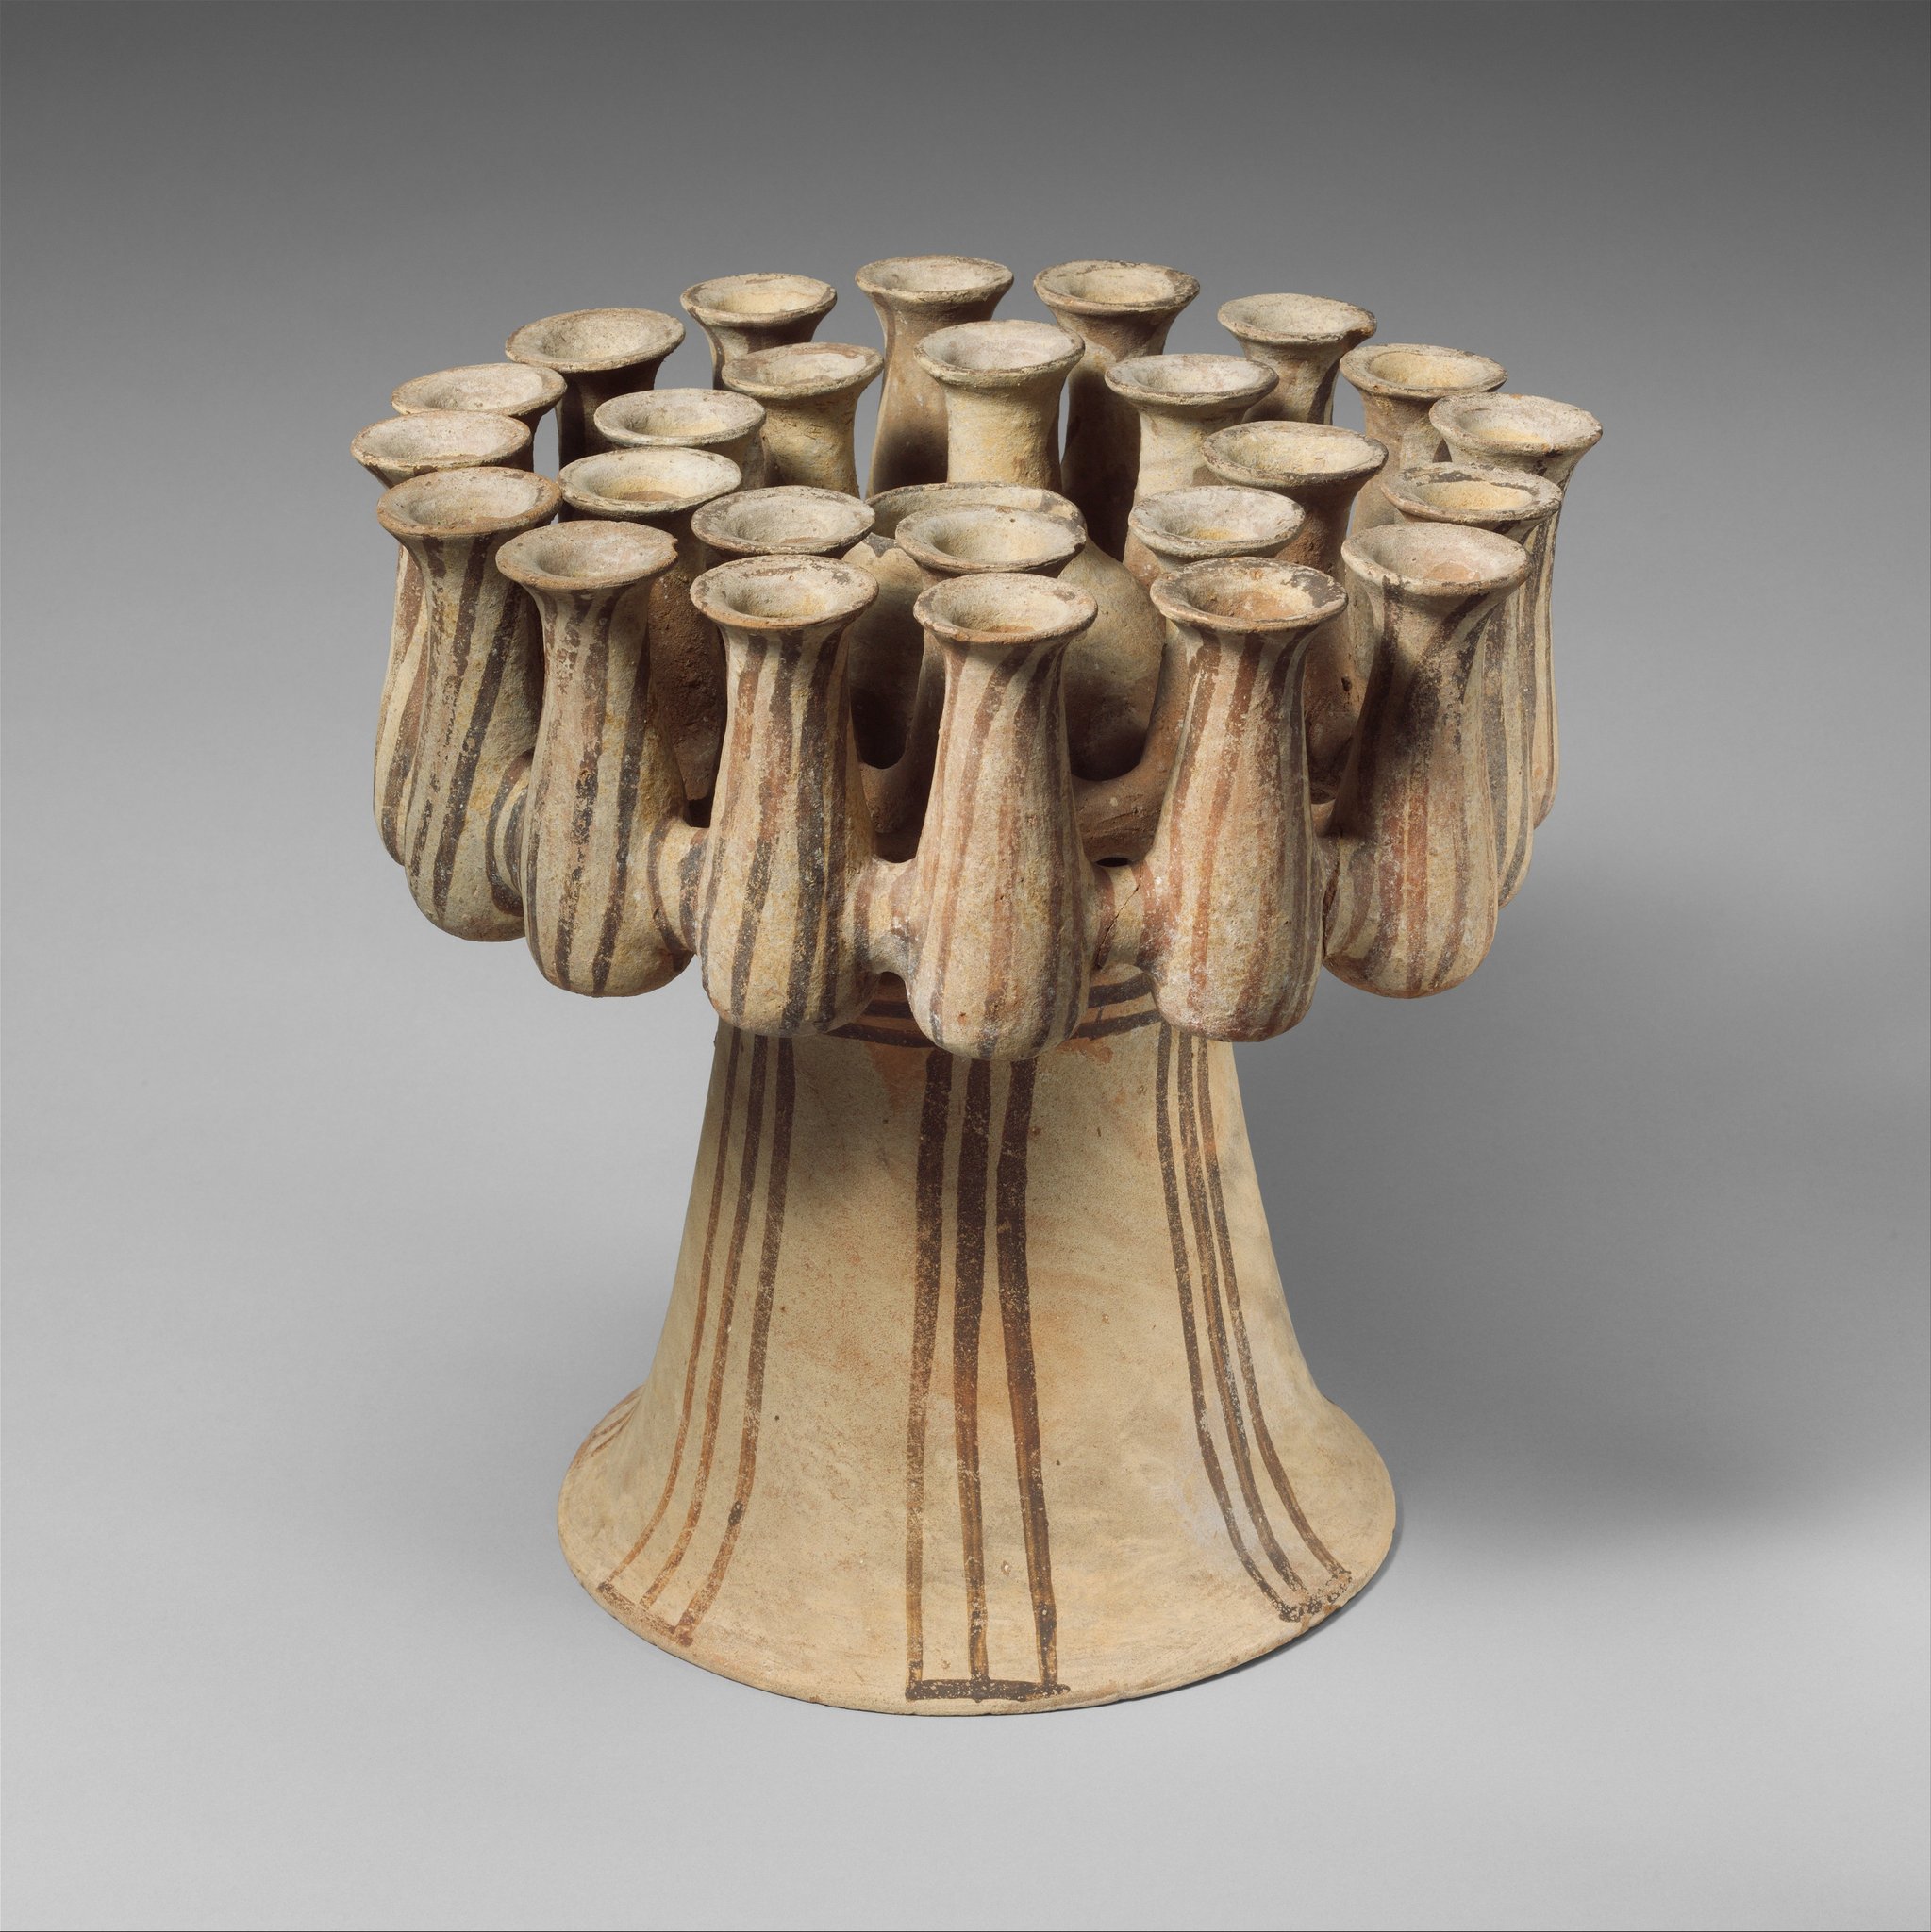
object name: kernos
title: Terracotta kernos (vase for multiple offerings)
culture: cycladic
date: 2300-1900 BCE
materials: terracotta